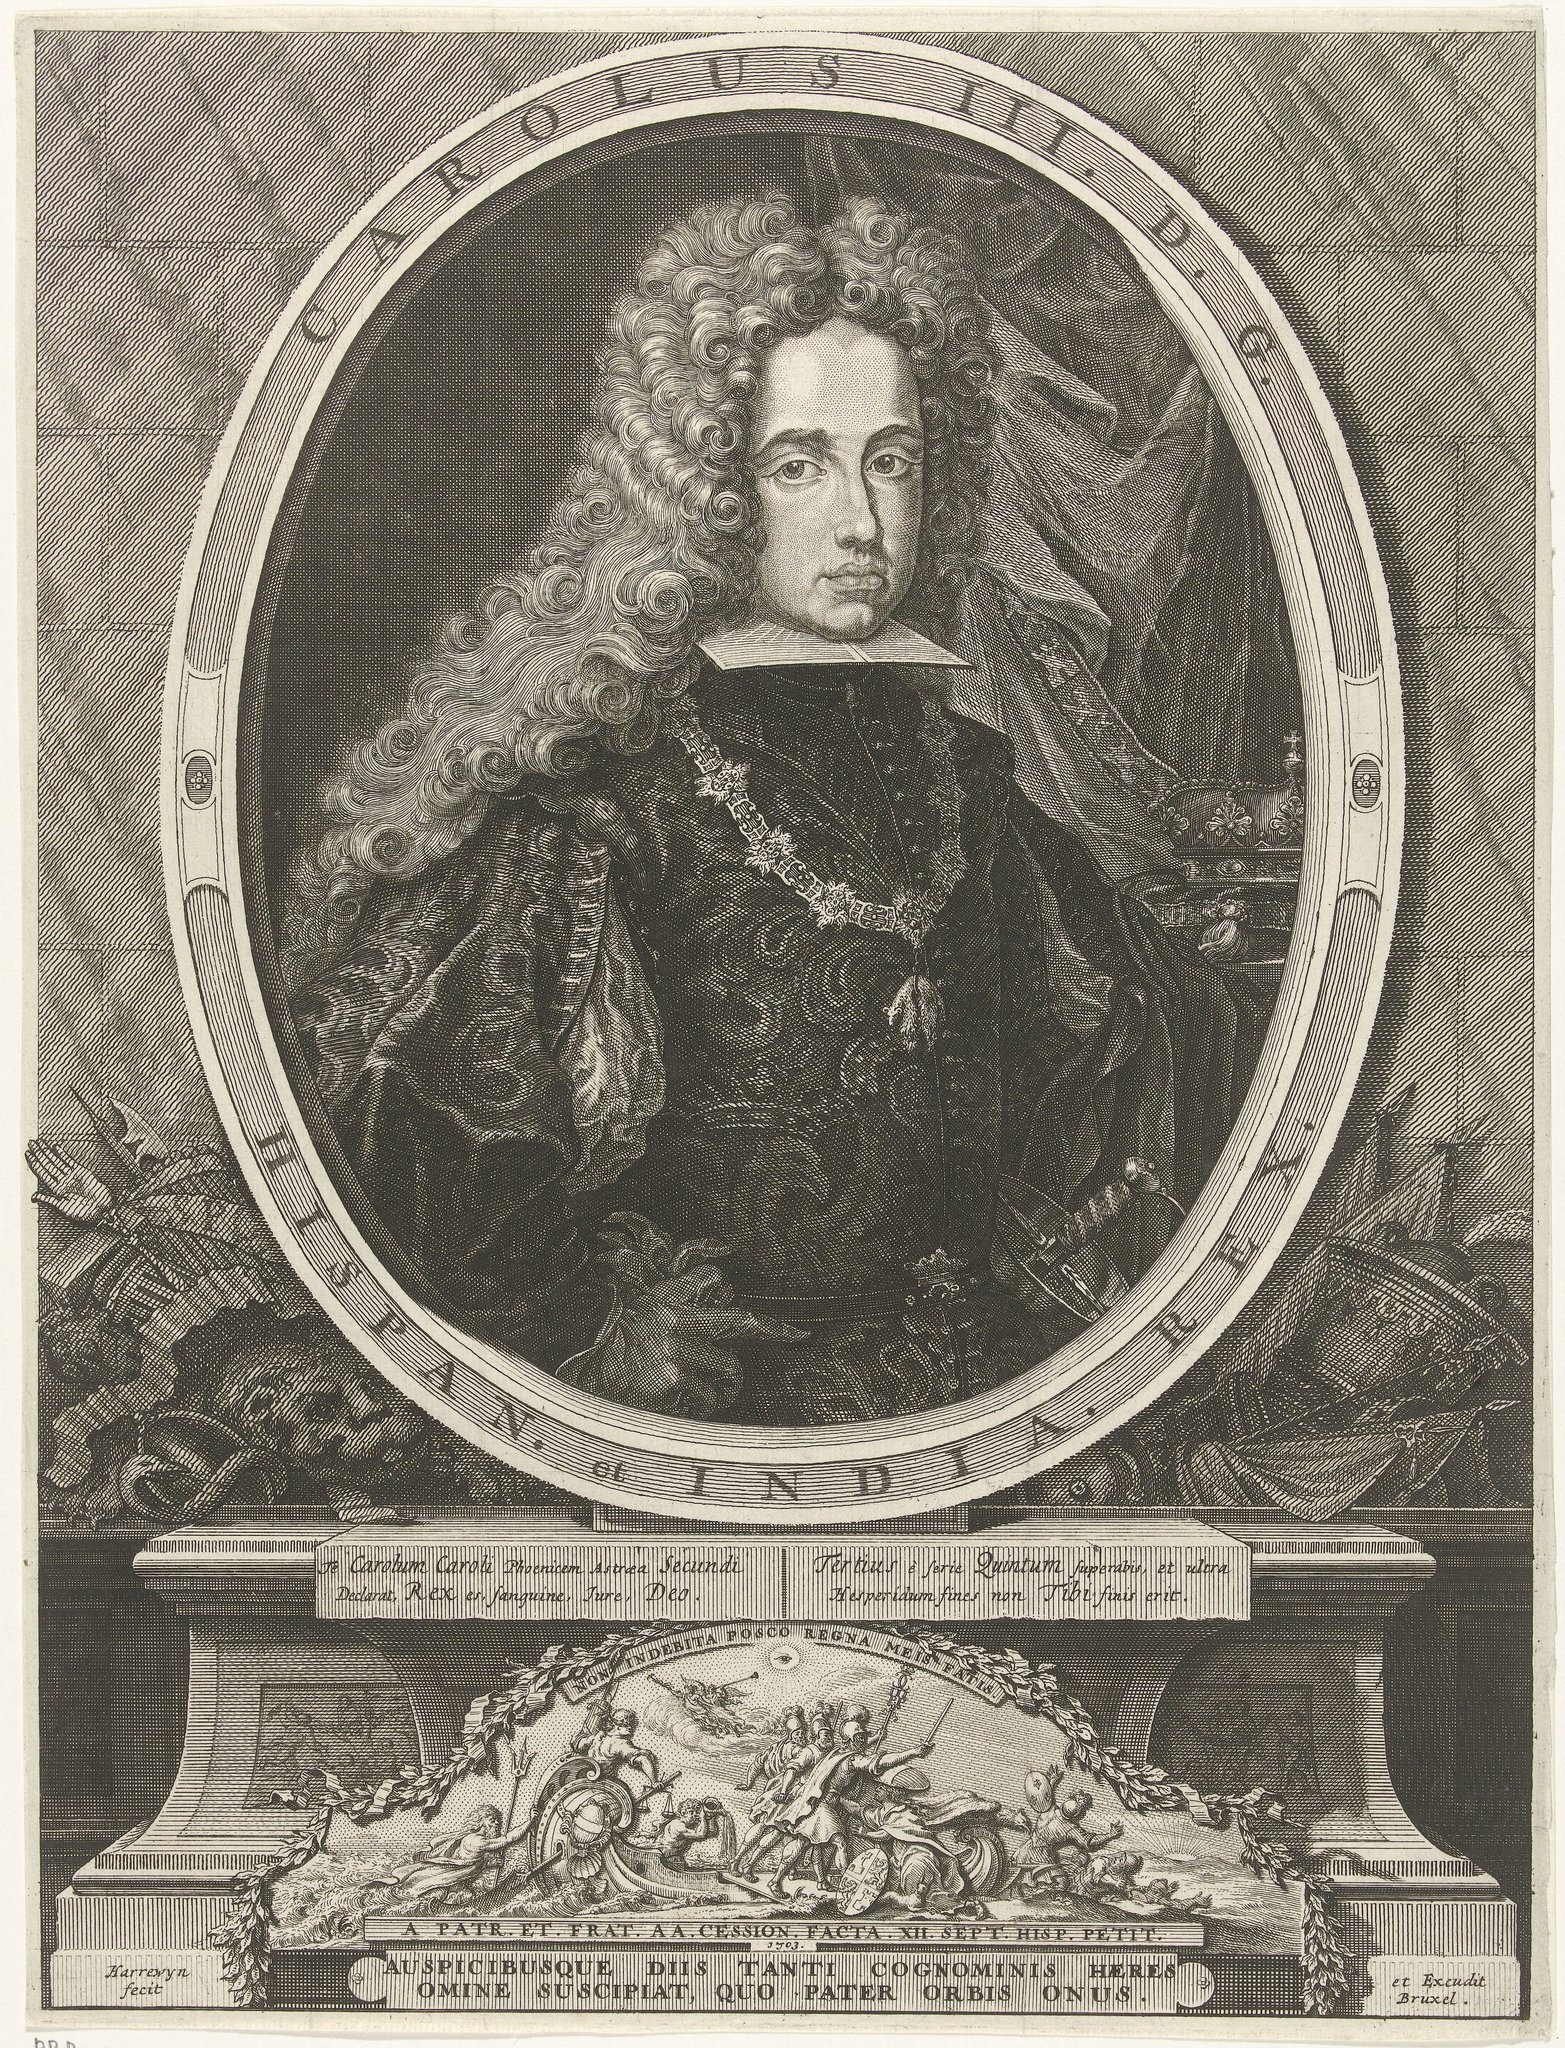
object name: print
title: Portret van keizer Karel VI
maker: jacobus harrewijn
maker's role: print maker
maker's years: 1660-1740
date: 1703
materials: paper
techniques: engraving, etching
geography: brussels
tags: charles vi (holy roman emperor), knighthood order of the golden fleece - insignia of a knighthood order, e.g.: badge, chain (with name of order)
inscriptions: collector's mark: Lugt 2228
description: Portret van Karel VI, Duits keizer, oftewel Karel III, koning van Spanje, ten halven lijve in een ovaal, met zijn handen in zijn zij en om zijn hals een ketting met het teken van de Orde van het Gulden Vlies. Onder het portret een afbeelding van een allegorische voorstelling en regels in het Latijn.